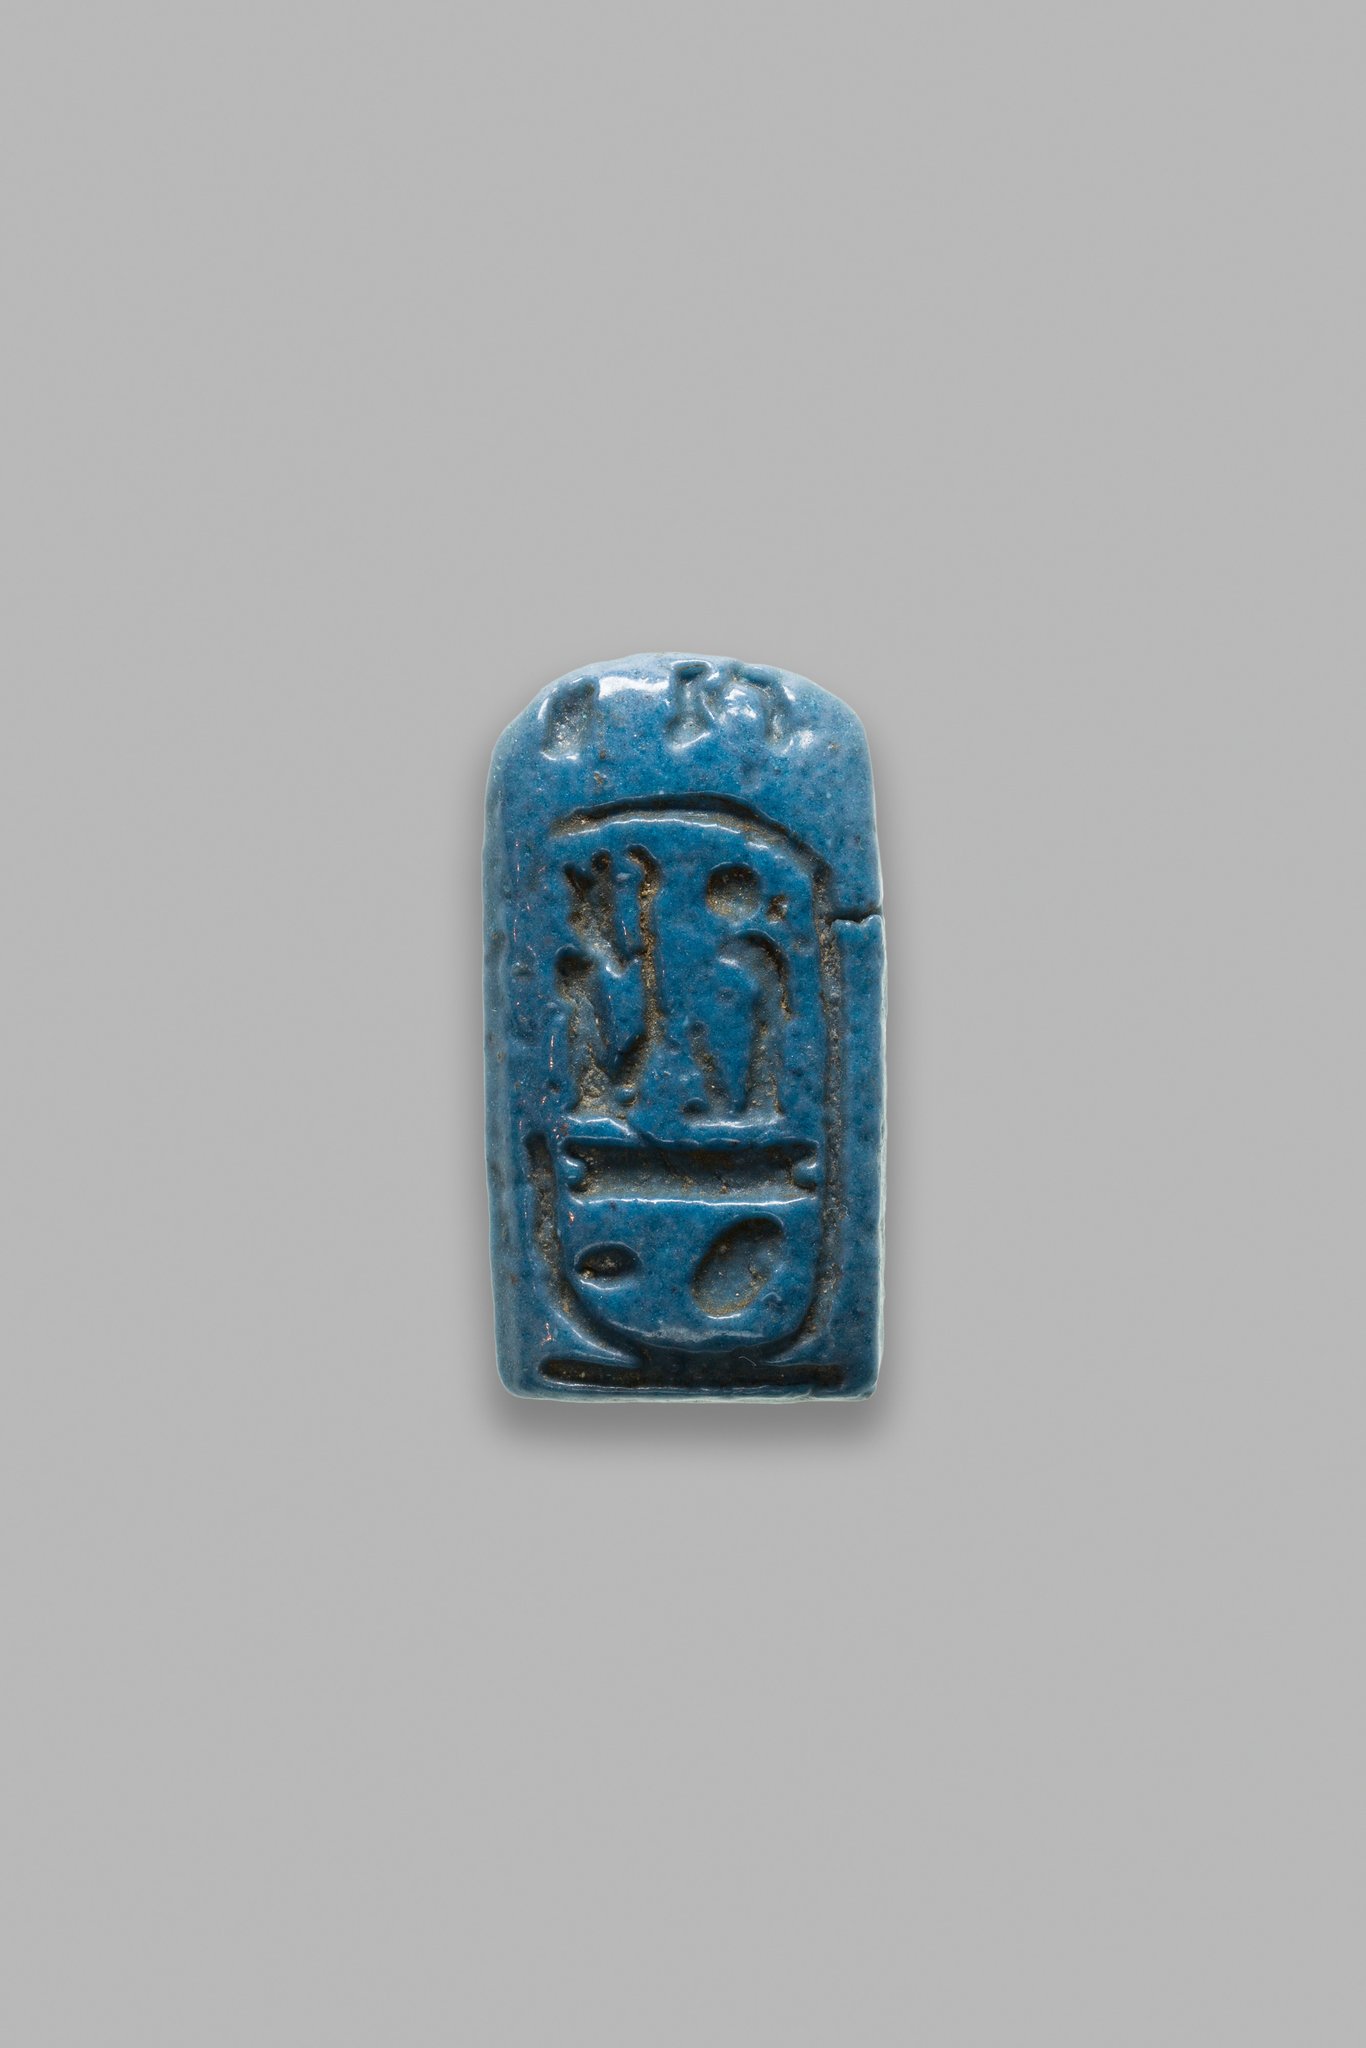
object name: plaque, cartouche, foundation deposit, tawosret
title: Plaque with the Cartouche of Tawosret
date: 1188-1186 BCE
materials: faience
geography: egypt